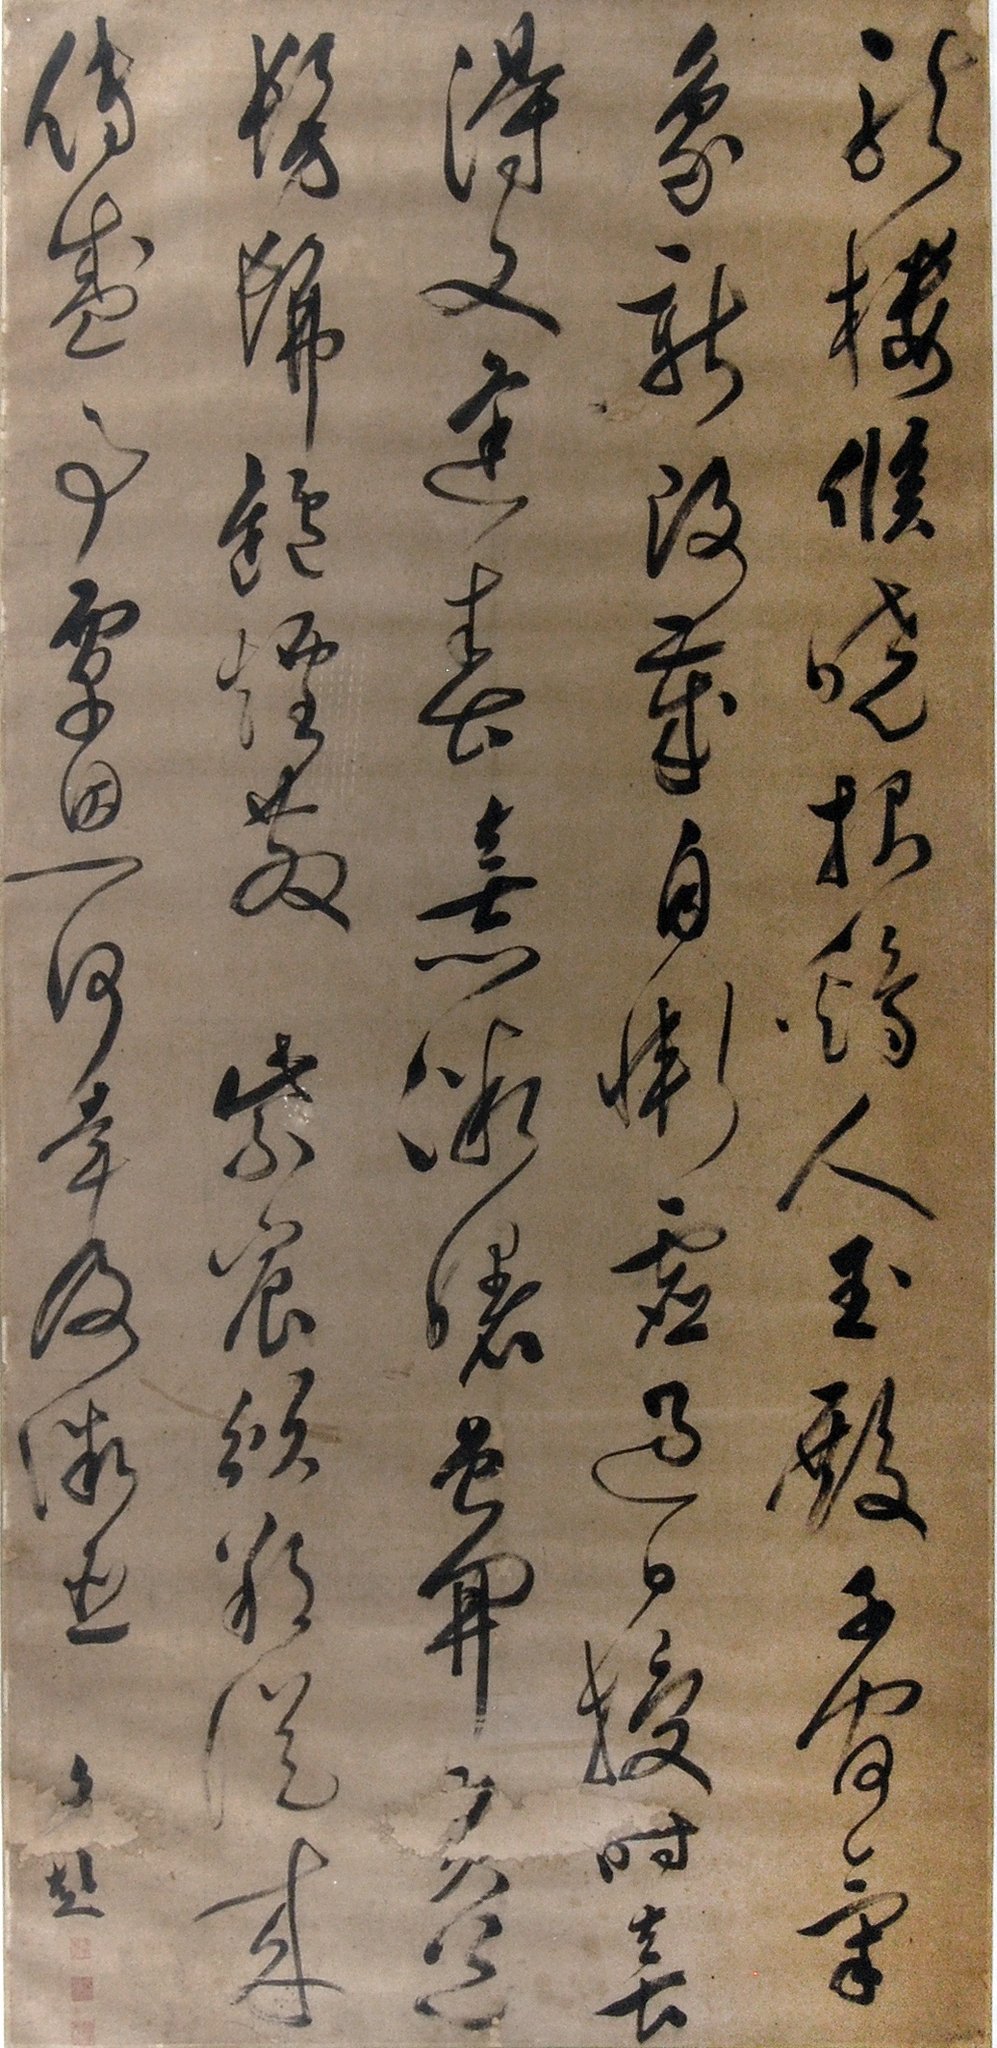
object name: hanging scroll mounted a panel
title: Poem on Promulgating the Almanac at New Year’s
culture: chinese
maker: wen peng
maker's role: artist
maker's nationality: chinese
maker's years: 1498-1573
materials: ink, panel, paper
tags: poetry,calligraphy